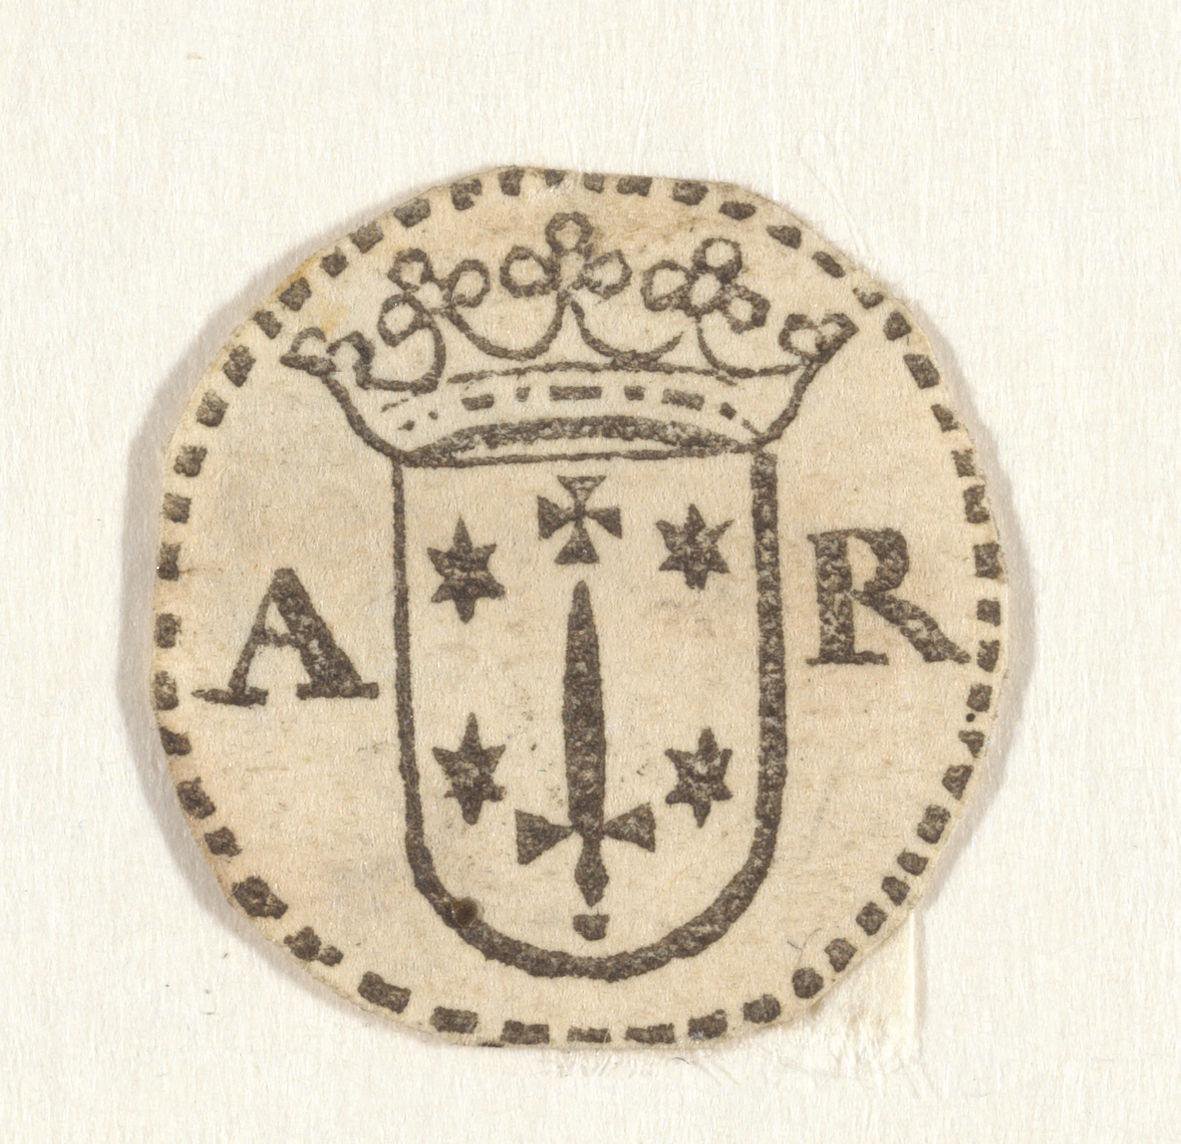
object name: print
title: Penning met het wapen van de stad Haarlem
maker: Anonymous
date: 1600-1699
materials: paper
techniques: woodcut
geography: netherlands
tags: coat of arms (as symbol of the state, etc.) (+ city; municipal), coin, haarlem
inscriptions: collector's mark: Lugt 240, collector's mark: Lugt 2228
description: Het wapen van de stad Haarlem met een kroon in een cirkel.